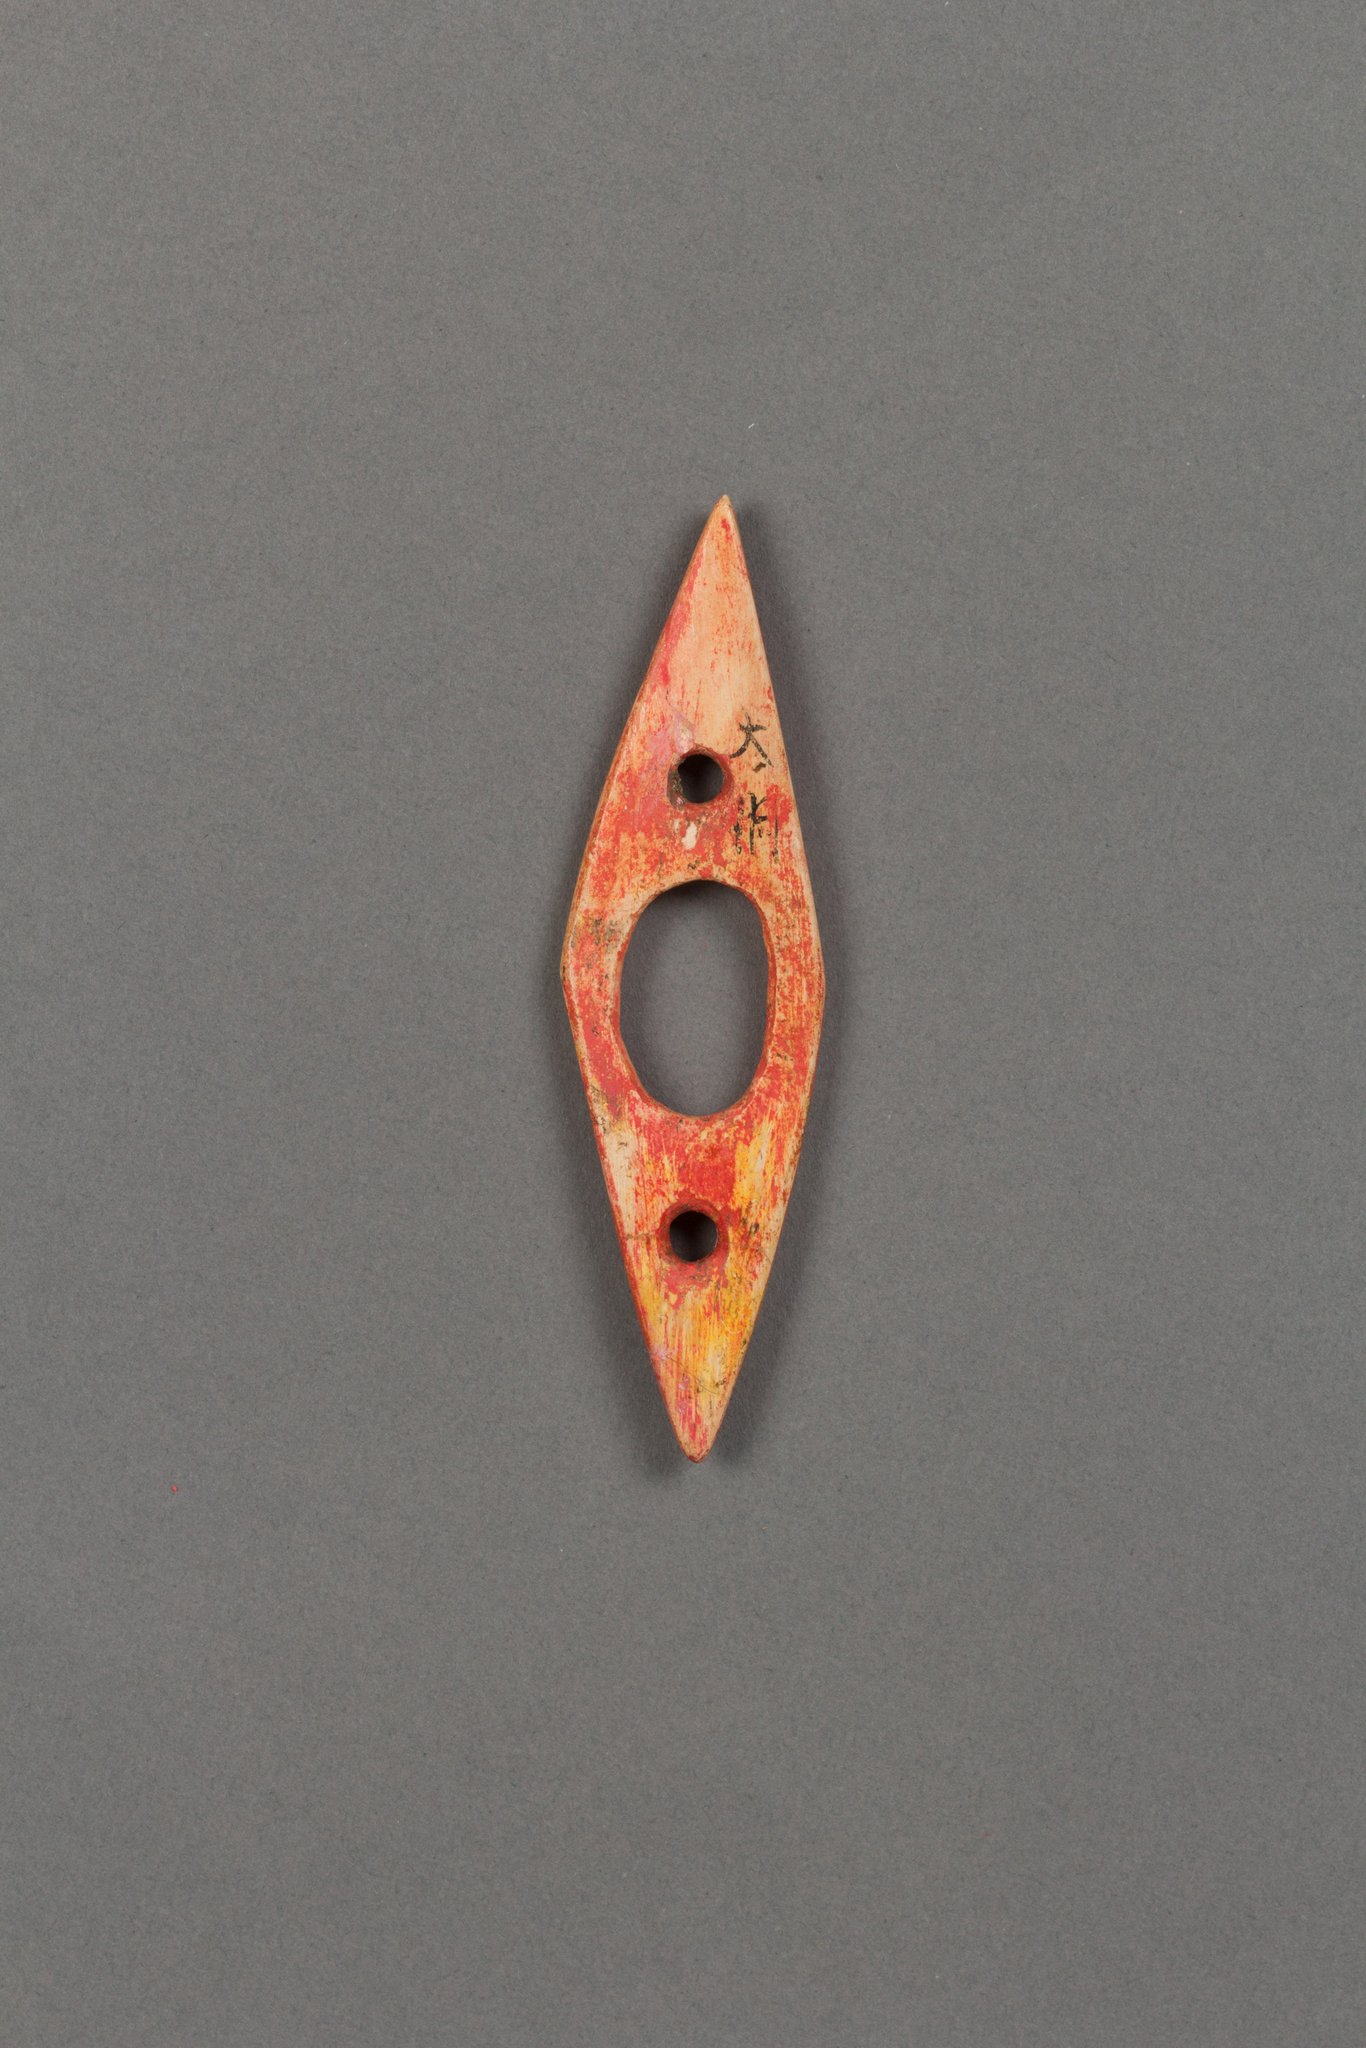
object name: ornament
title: Body Ornament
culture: japanese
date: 1000-300 BCE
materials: bone